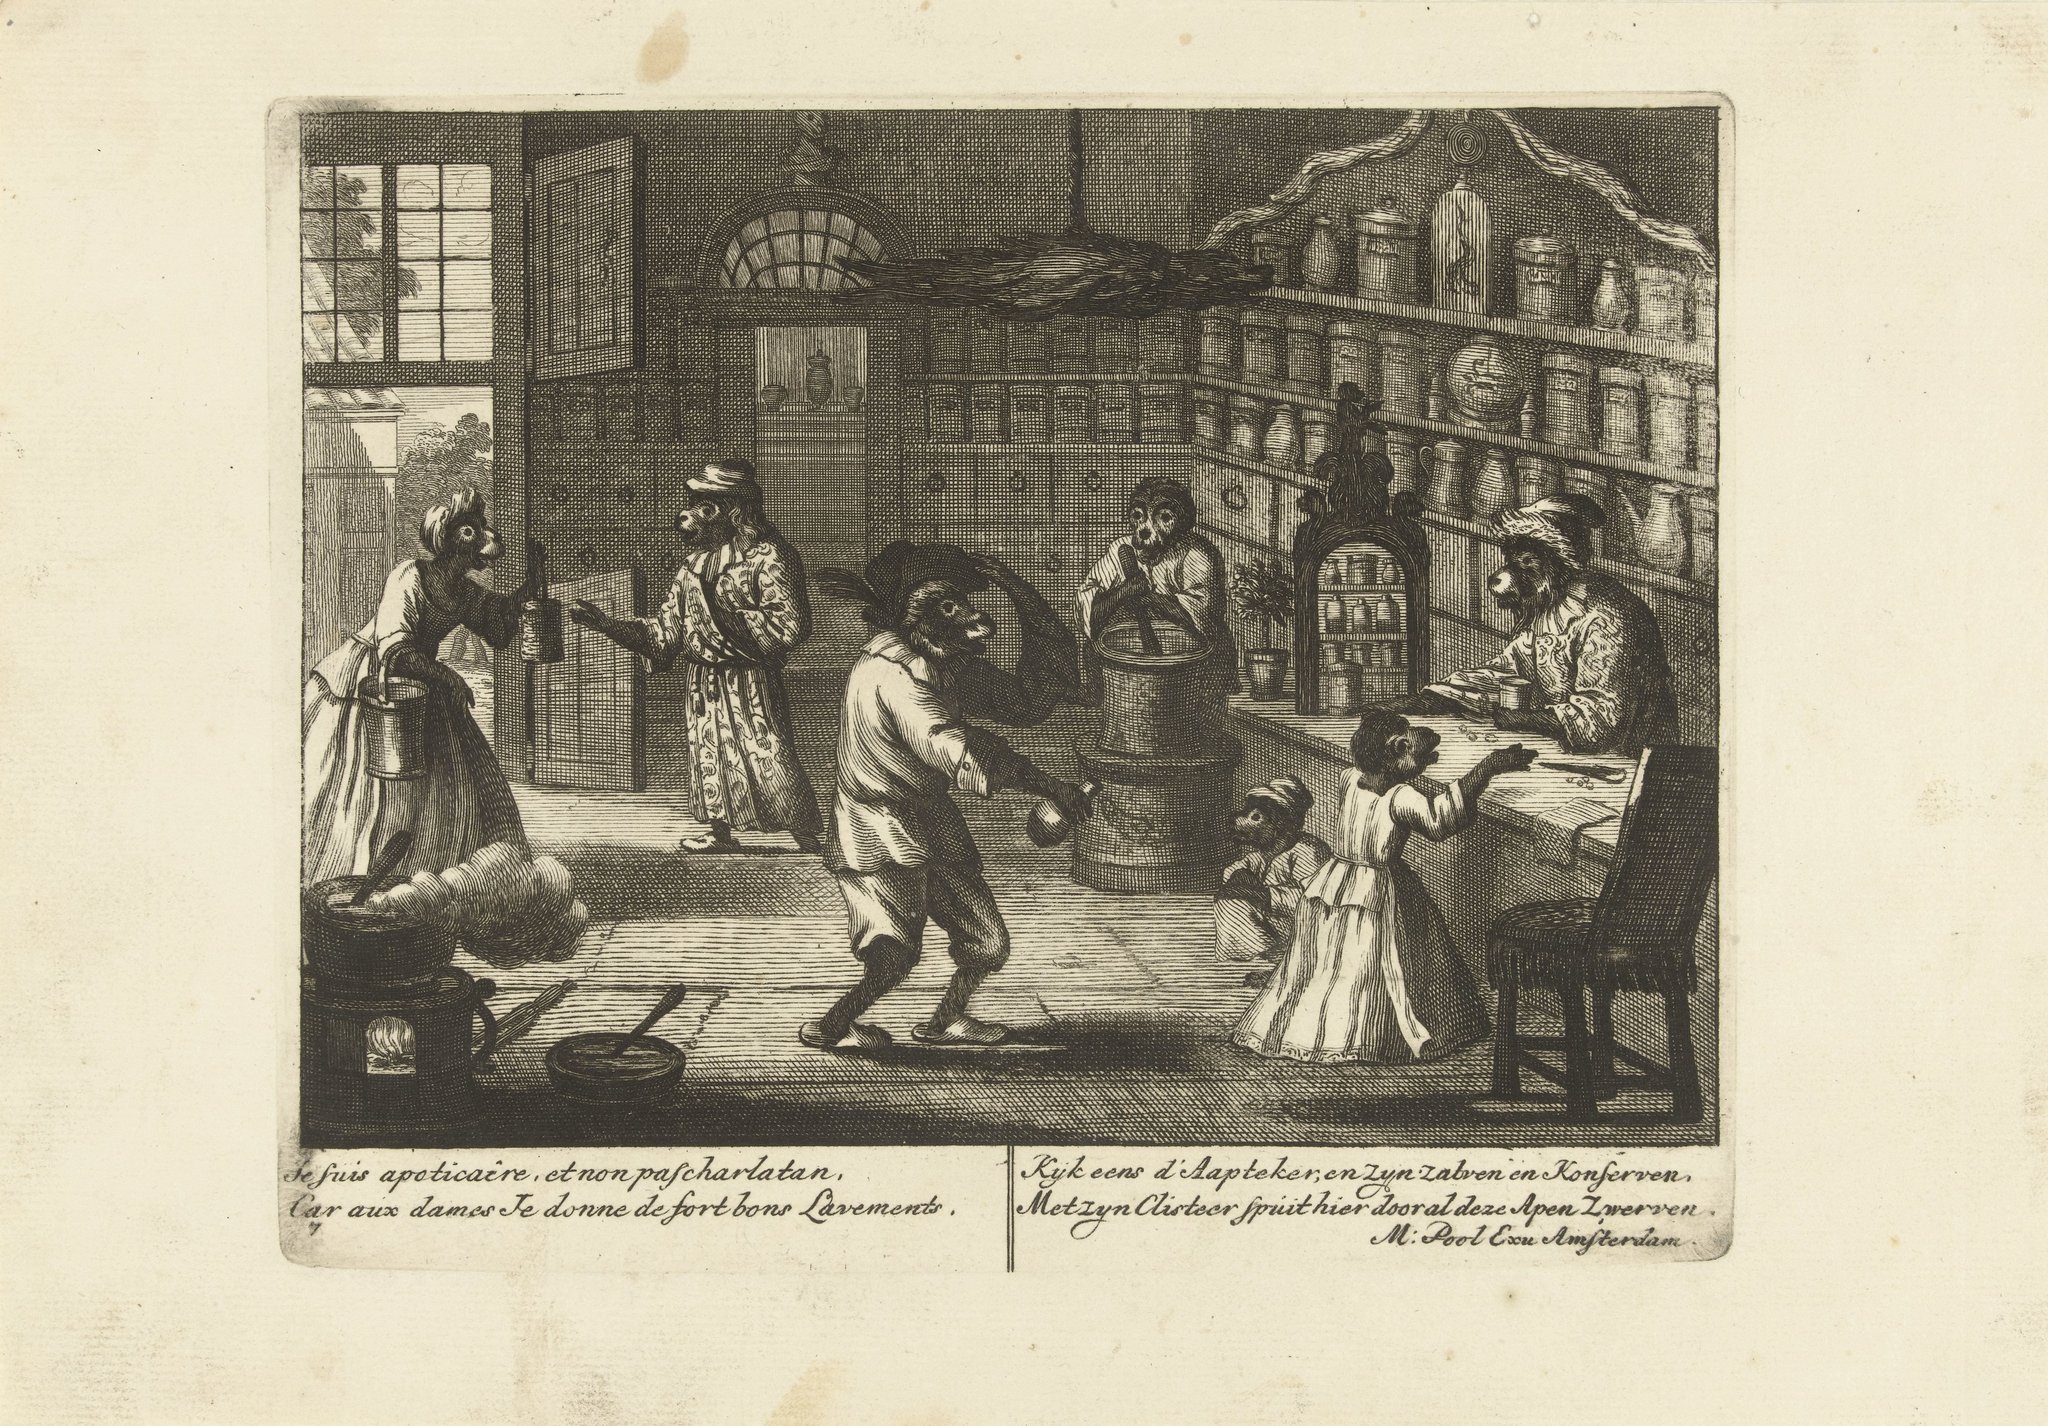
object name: print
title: Apenspel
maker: matthijs pool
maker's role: print maker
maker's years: 1676-1740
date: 1720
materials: paper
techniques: engraving, etching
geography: amsterdam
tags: pharmacist, druggist, apothecary; pharmacy, drugstore, dispensing chemist, monkeys, apes, animals acting as human beings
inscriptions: collector's mark: Lugt 2228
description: Apen als apothekers en klanten in een apotheek. In het onderschrift versjes in het Frans en Nederlands. Prent nr. 7 in een serie van 16 prenten van ca. 1720 waarin apen als mensen figureren in allerlei huishoudelijke taferelen.